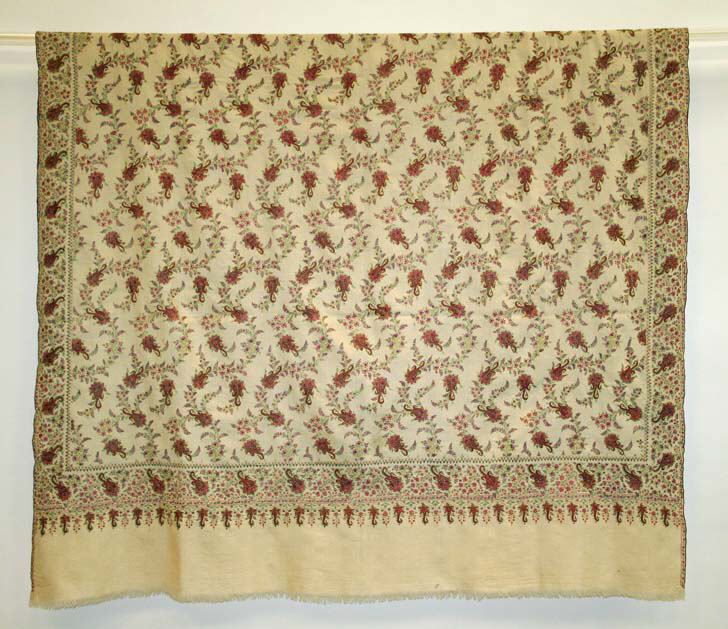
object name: shawl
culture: indian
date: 1801-1900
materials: silk, wool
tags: flowers